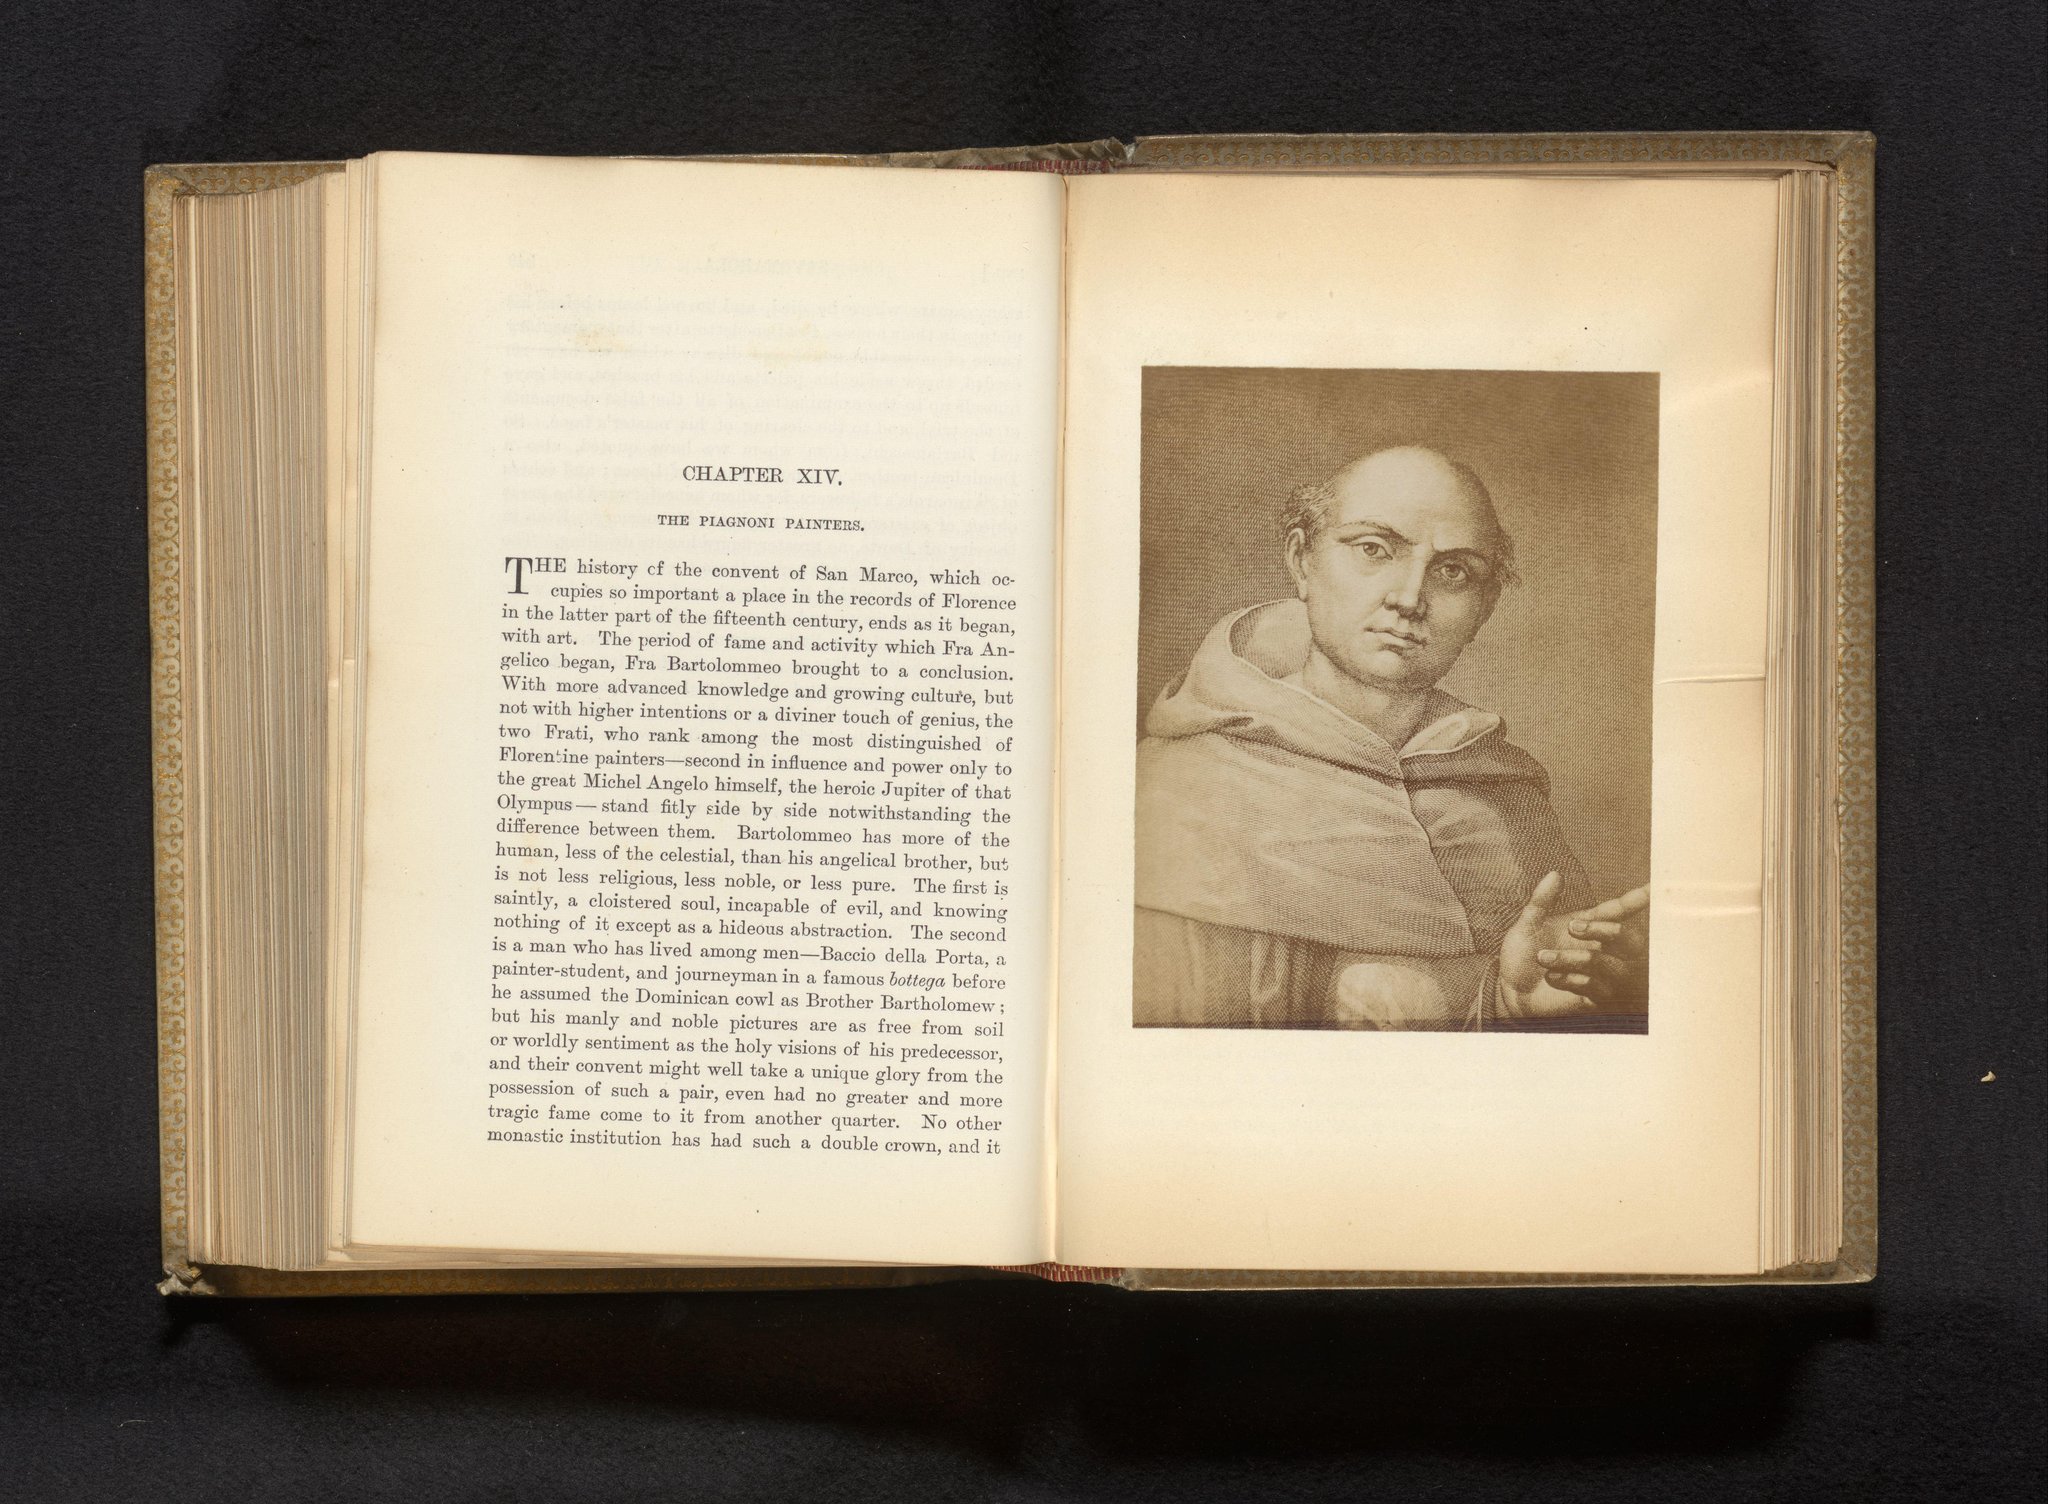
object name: photograph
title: Fotoreproductie van een prent, voorstellende een portret van Fra Bartolommeo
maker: Anonymous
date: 1878-1888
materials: photographic support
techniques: albumen print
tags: draughtsman, bartolommeo (fra), portrait, self-portrait of painter